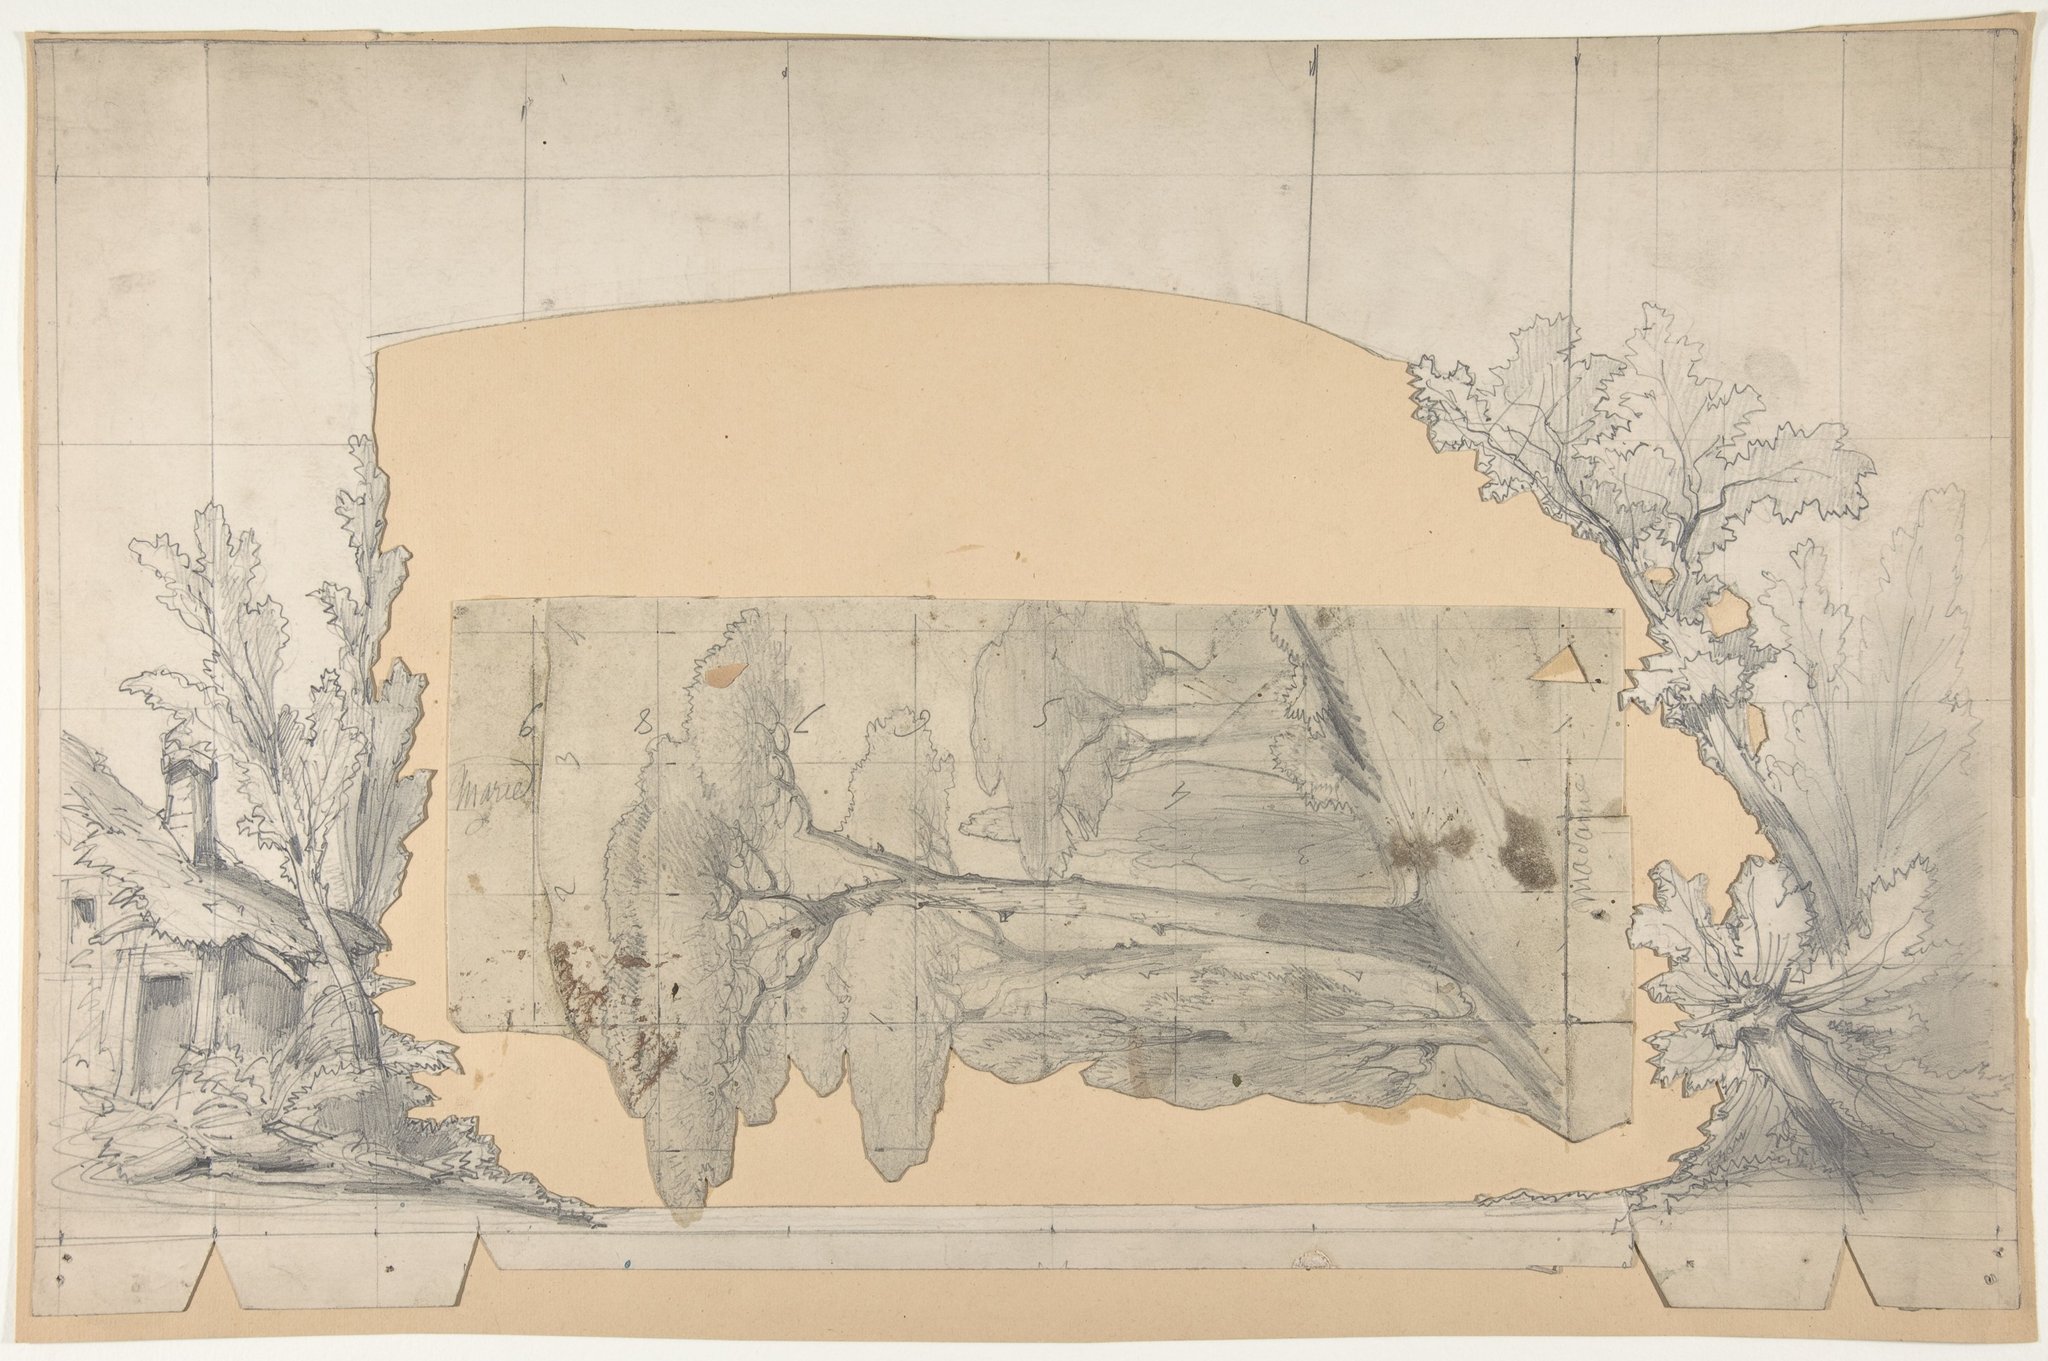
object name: drawing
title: Design for a Stage Set at the Opéra, Paris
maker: eugène cicéri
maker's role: artist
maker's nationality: french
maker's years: 1813-1890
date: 1830-1890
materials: graphite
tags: trees,stage design